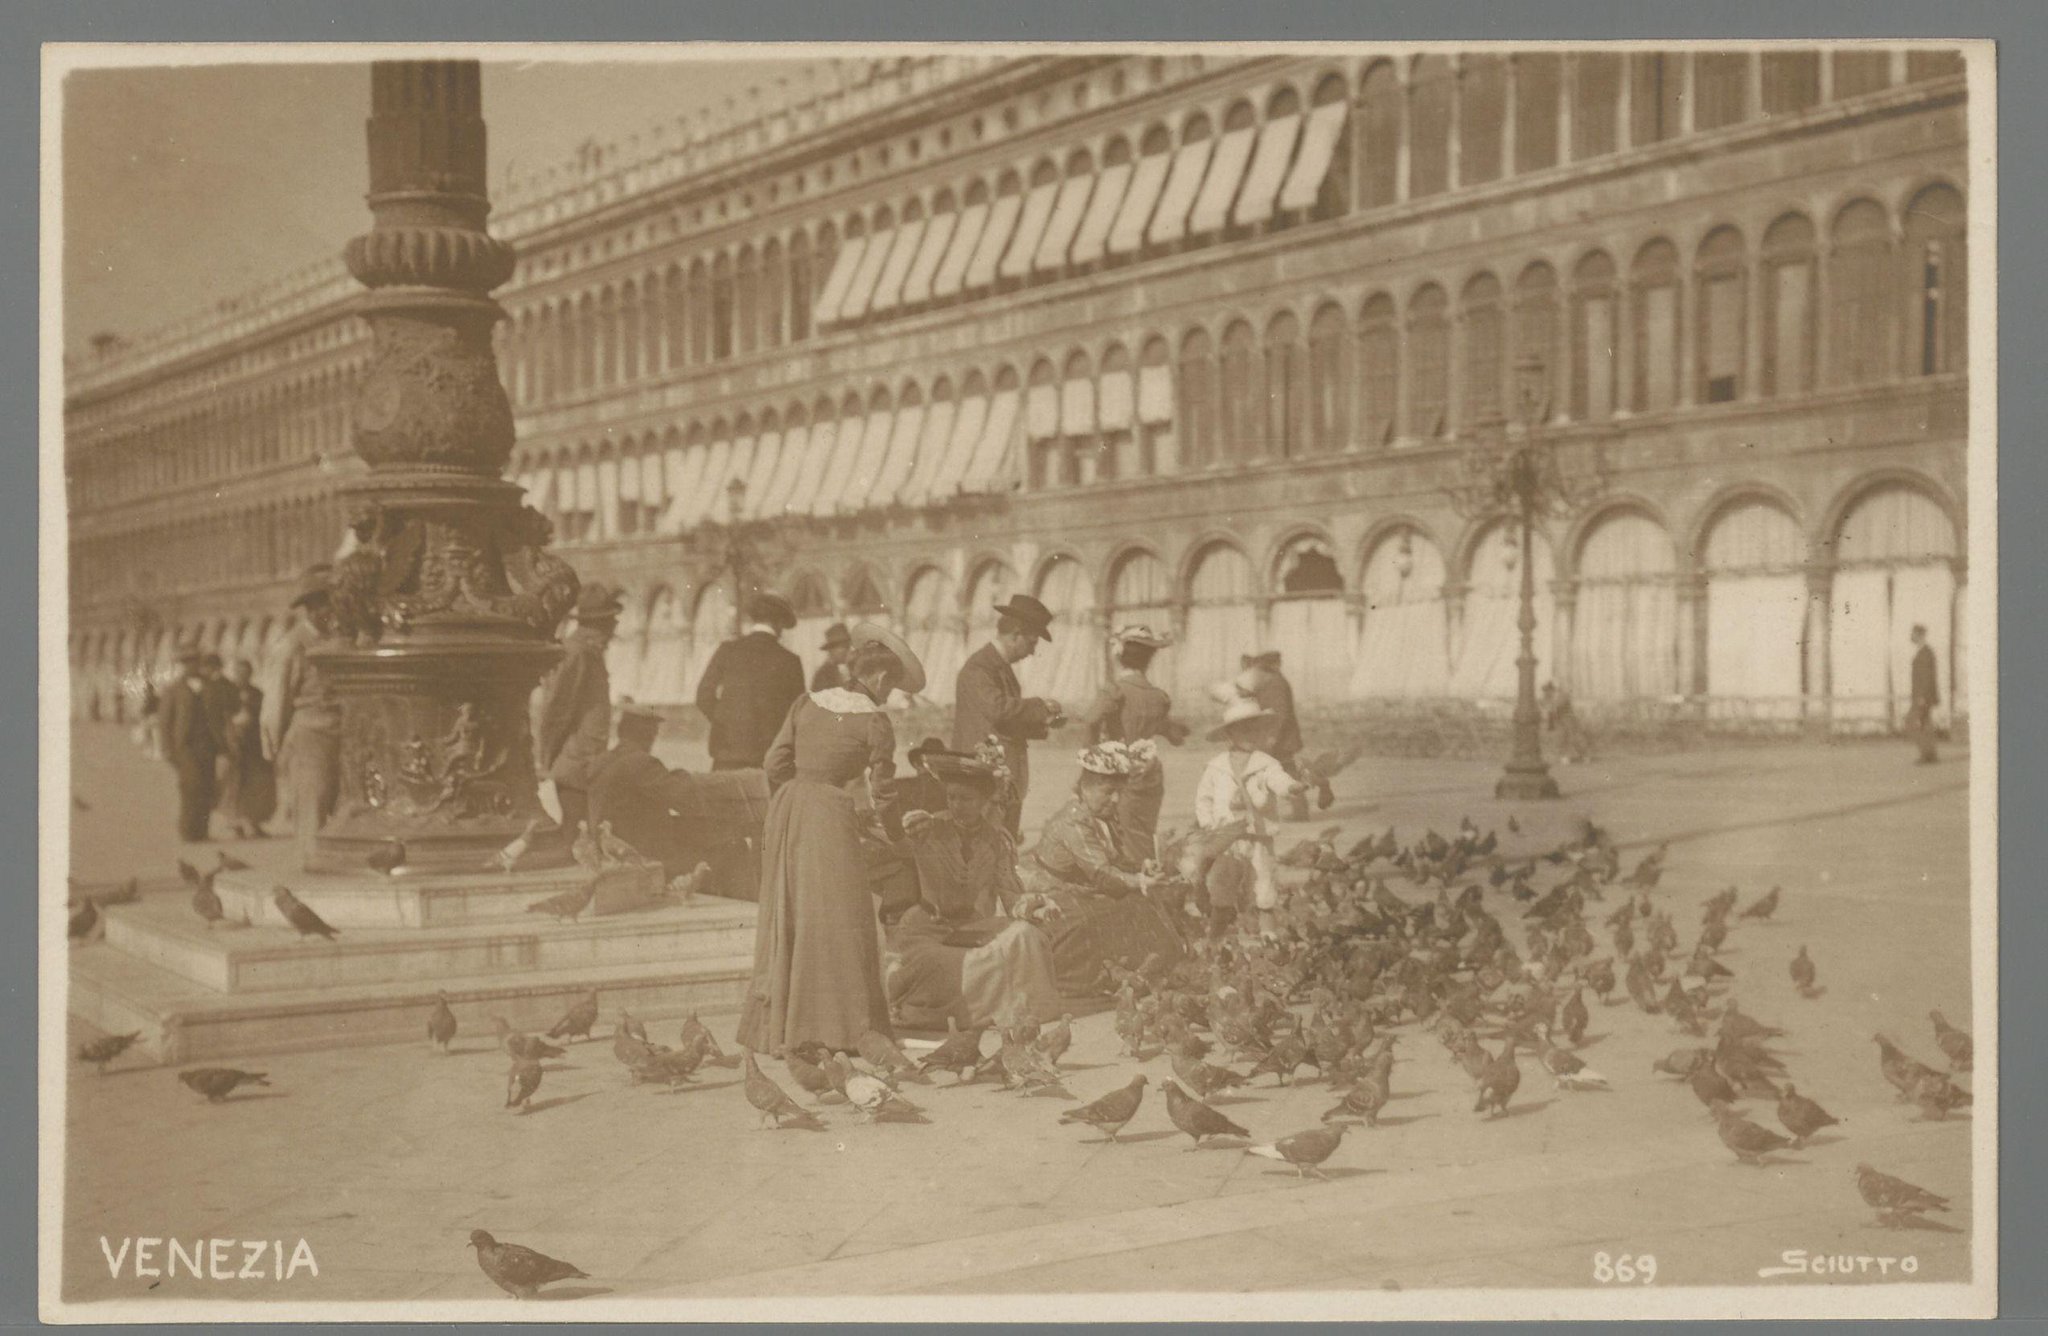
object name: ansichtkaart, prentbriefkaart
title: Venezia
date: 1906-1920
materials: photographic support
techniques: photography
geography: venice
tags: doves, pigeons (+ feeding animal), square, place, circus, etc. (+ city(-scape) with figures, staffage), venice